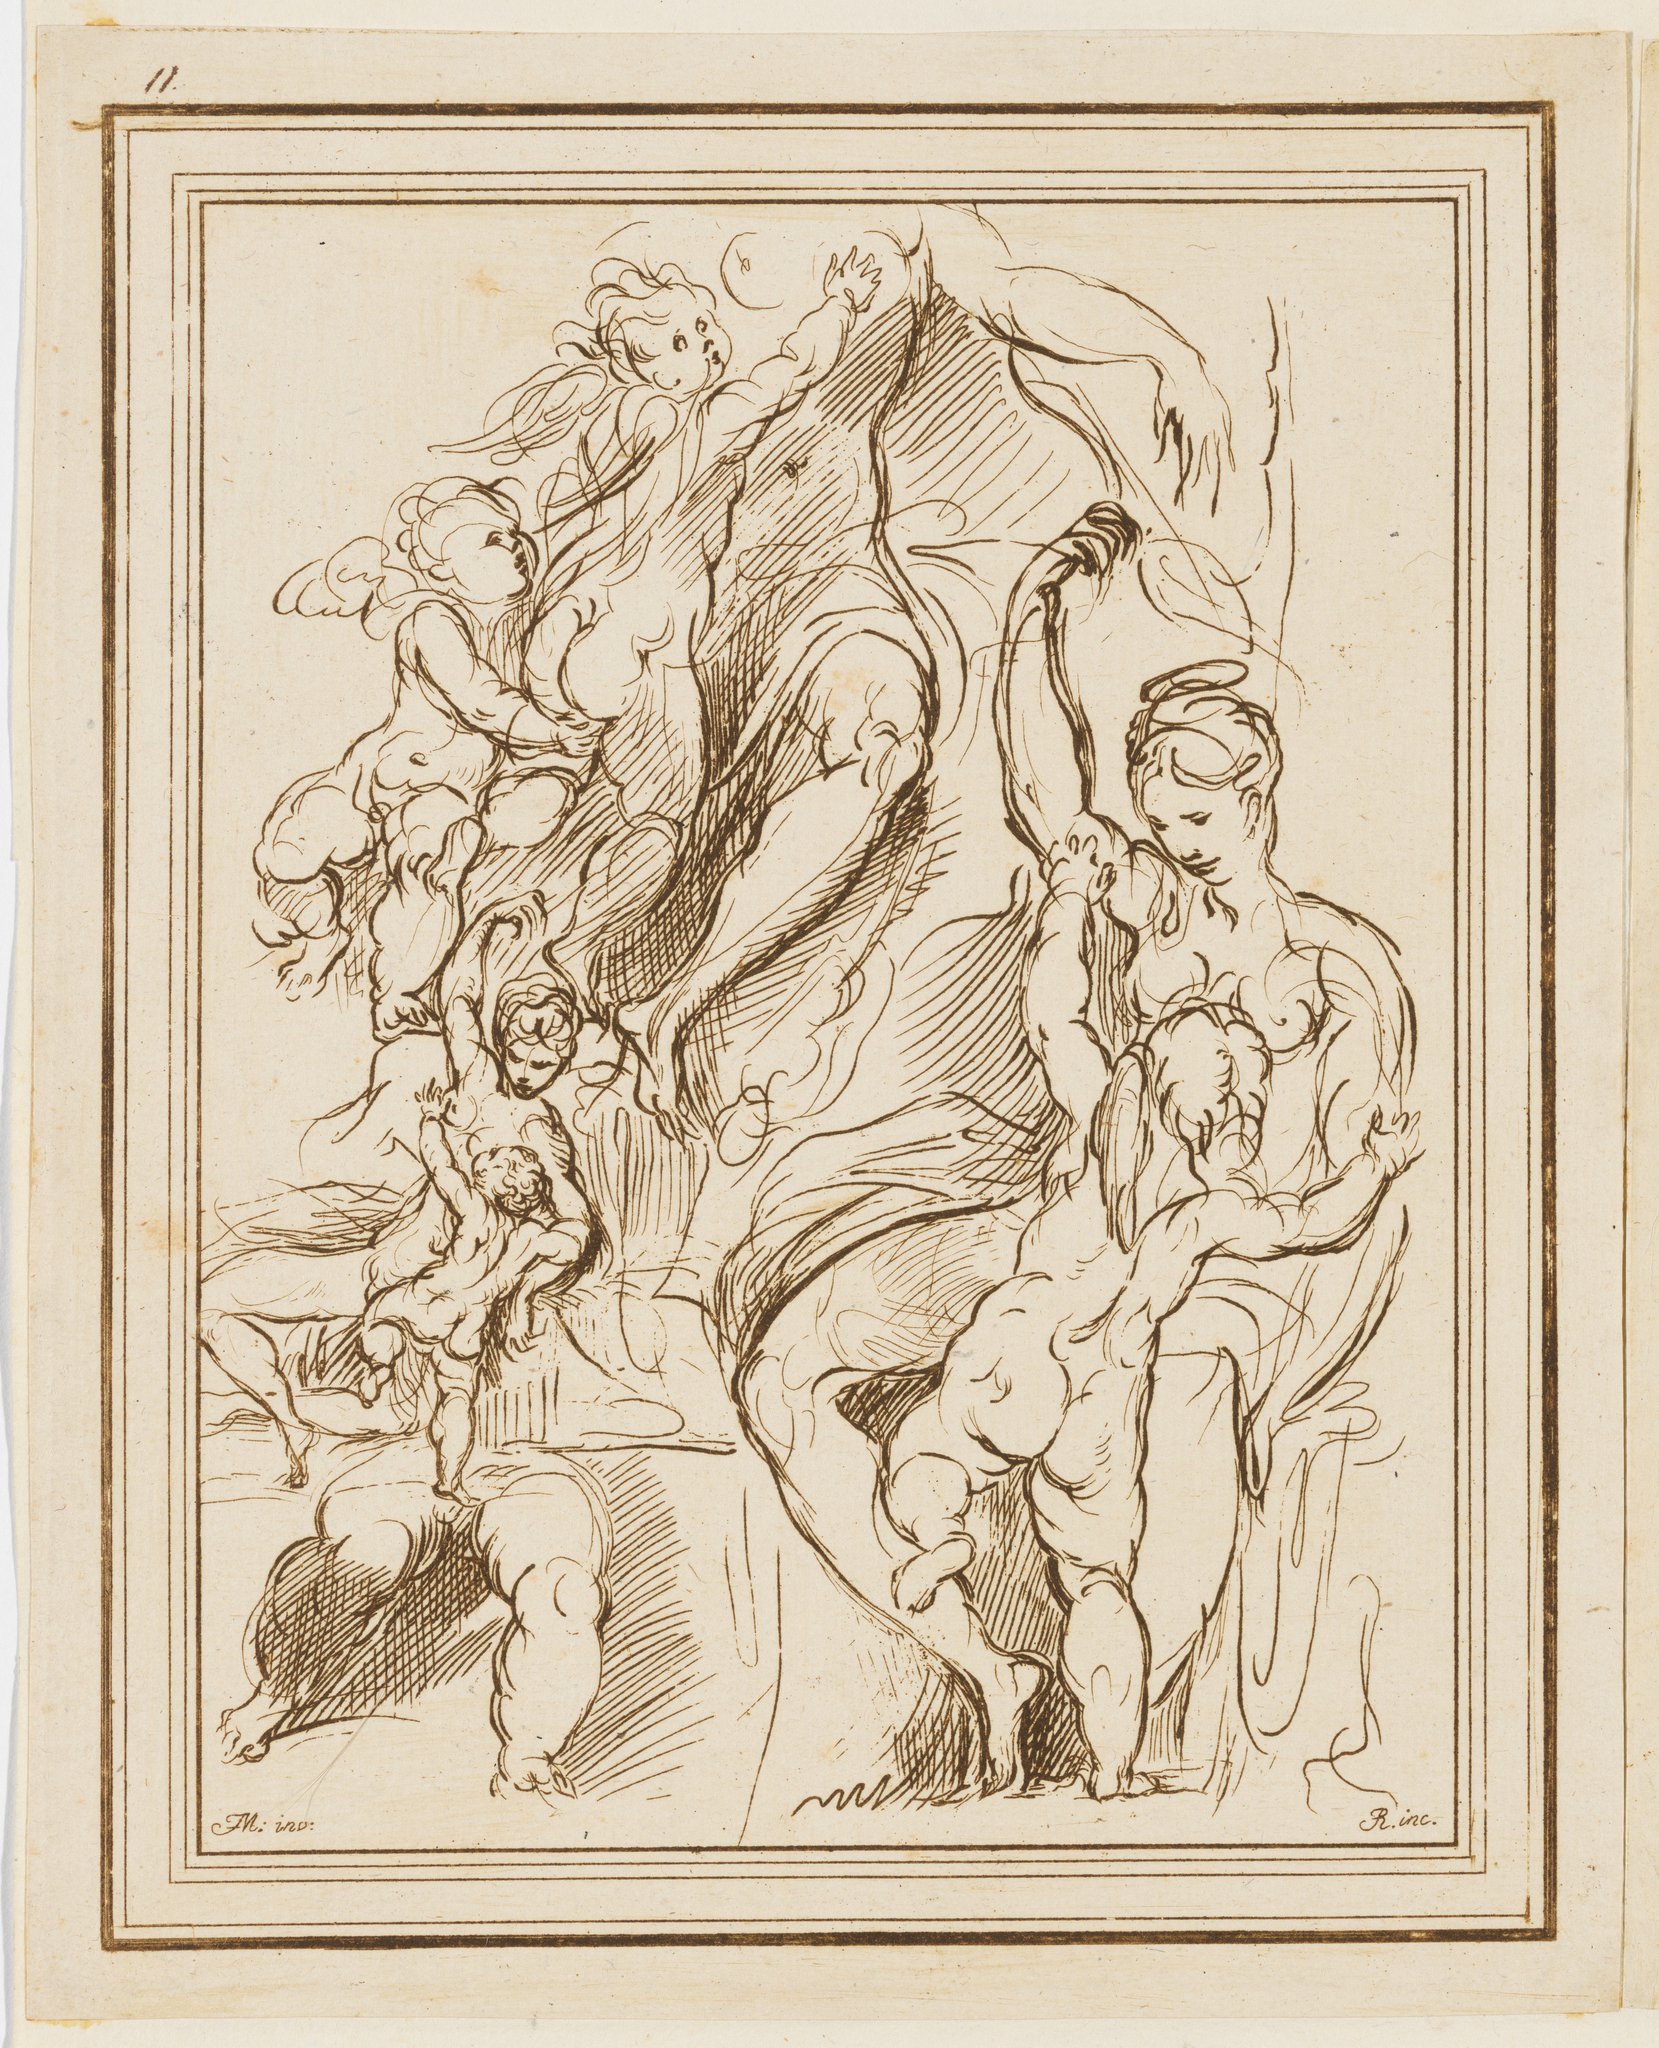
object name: print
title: Study of Venus and Cupid, from Prove di Vari Rami Inediti [...]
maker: francesco rosaspina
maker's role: artist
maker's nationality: italian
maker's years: 1762-1841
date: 1801-1900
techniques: etching